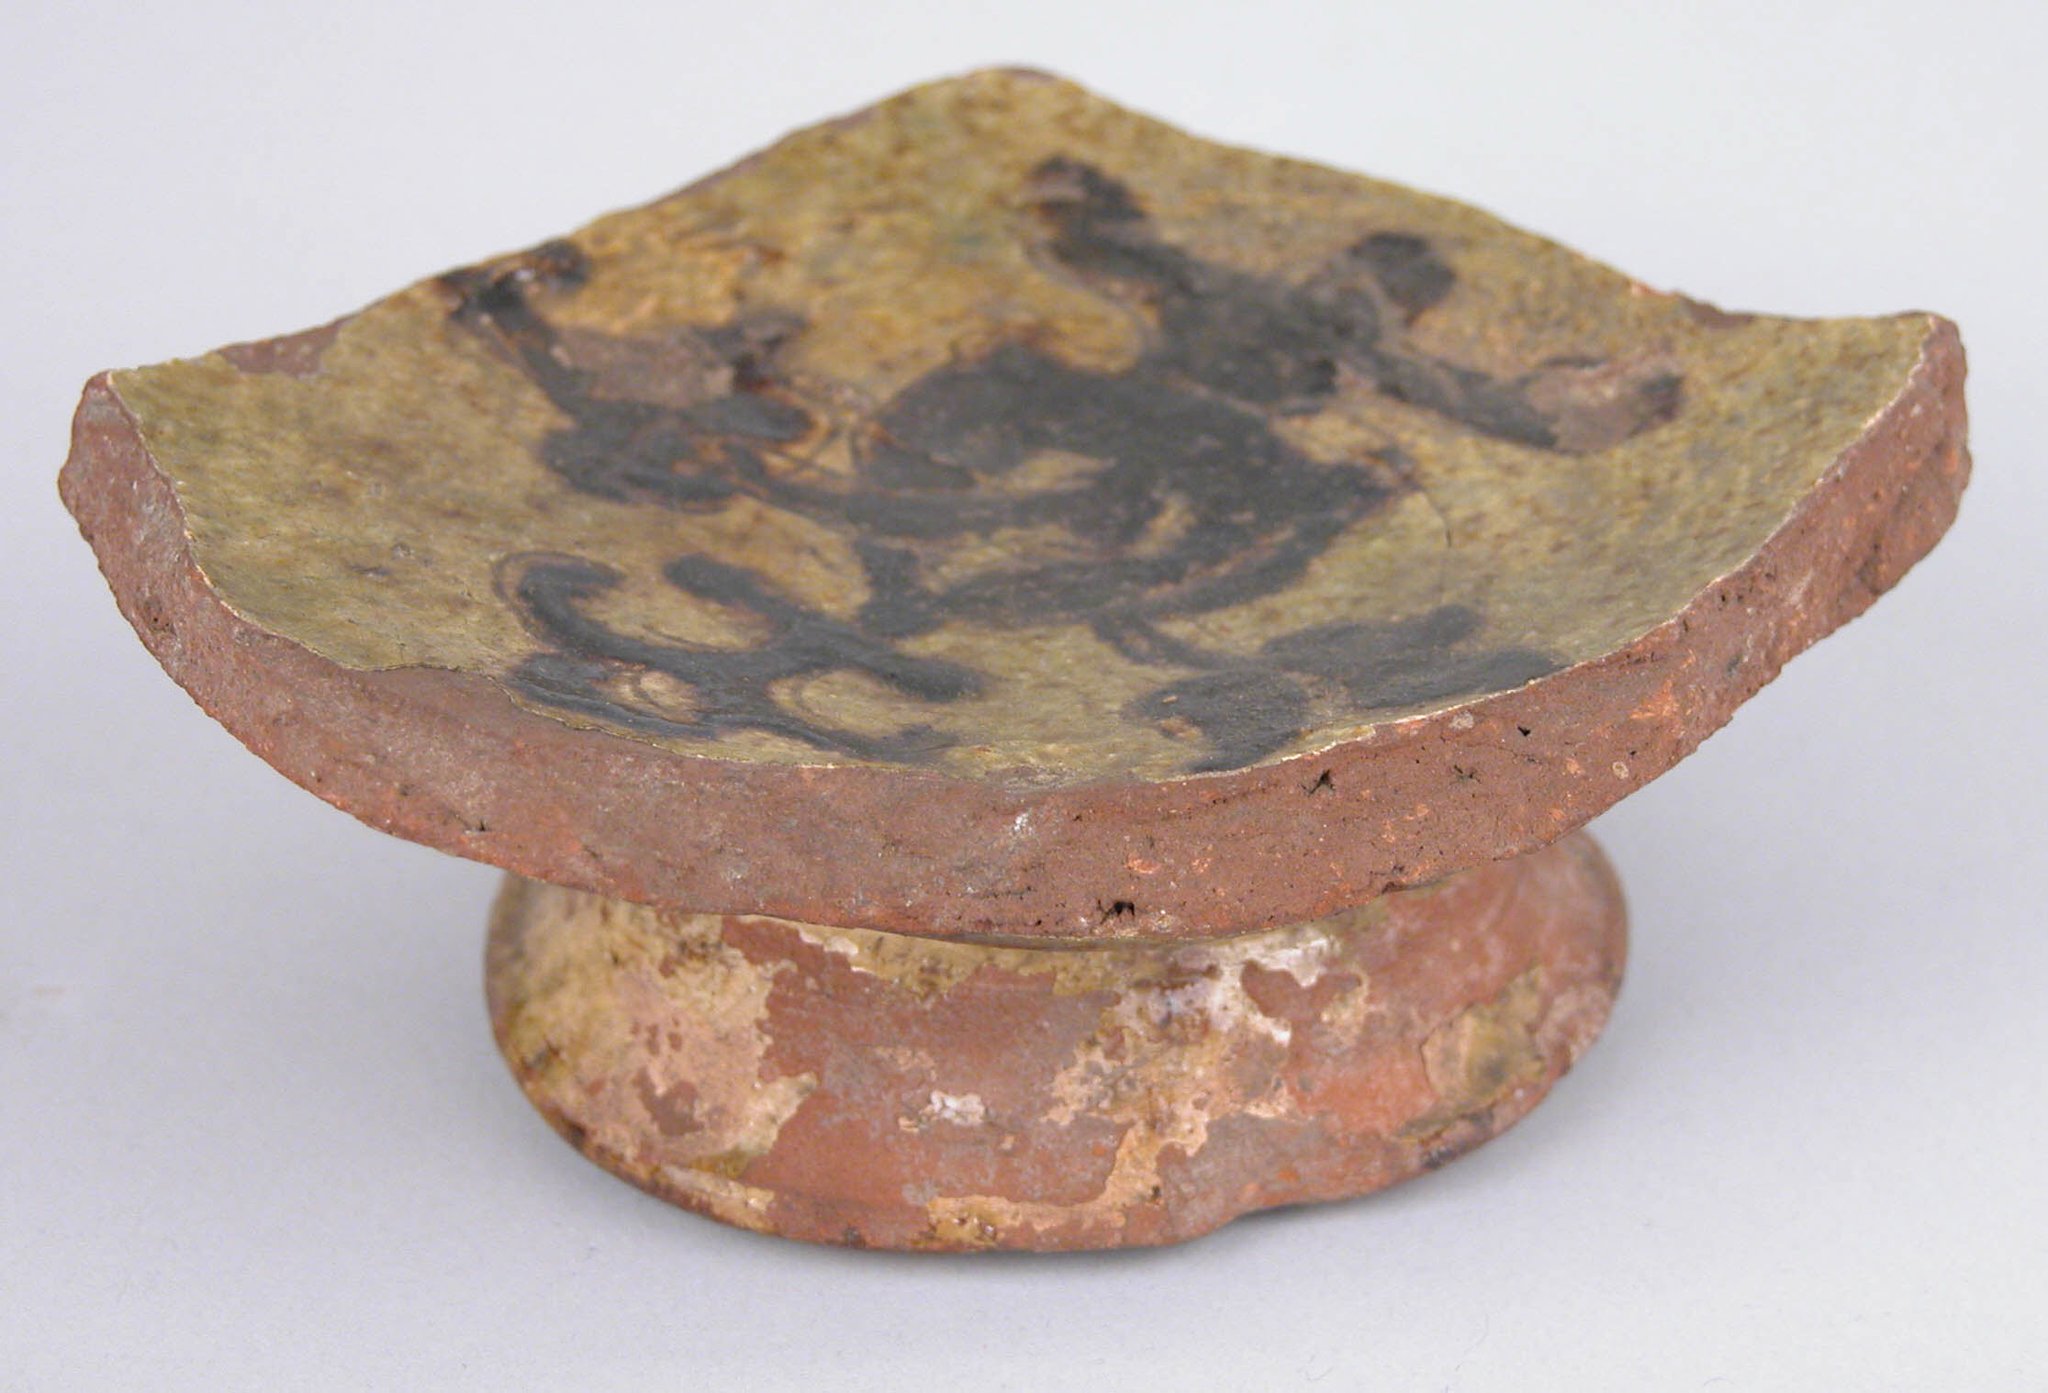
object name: fragment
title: Fragment of a Bowl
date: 1301-1500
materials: earthenware, glaze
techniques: coloring, incising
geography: egypt